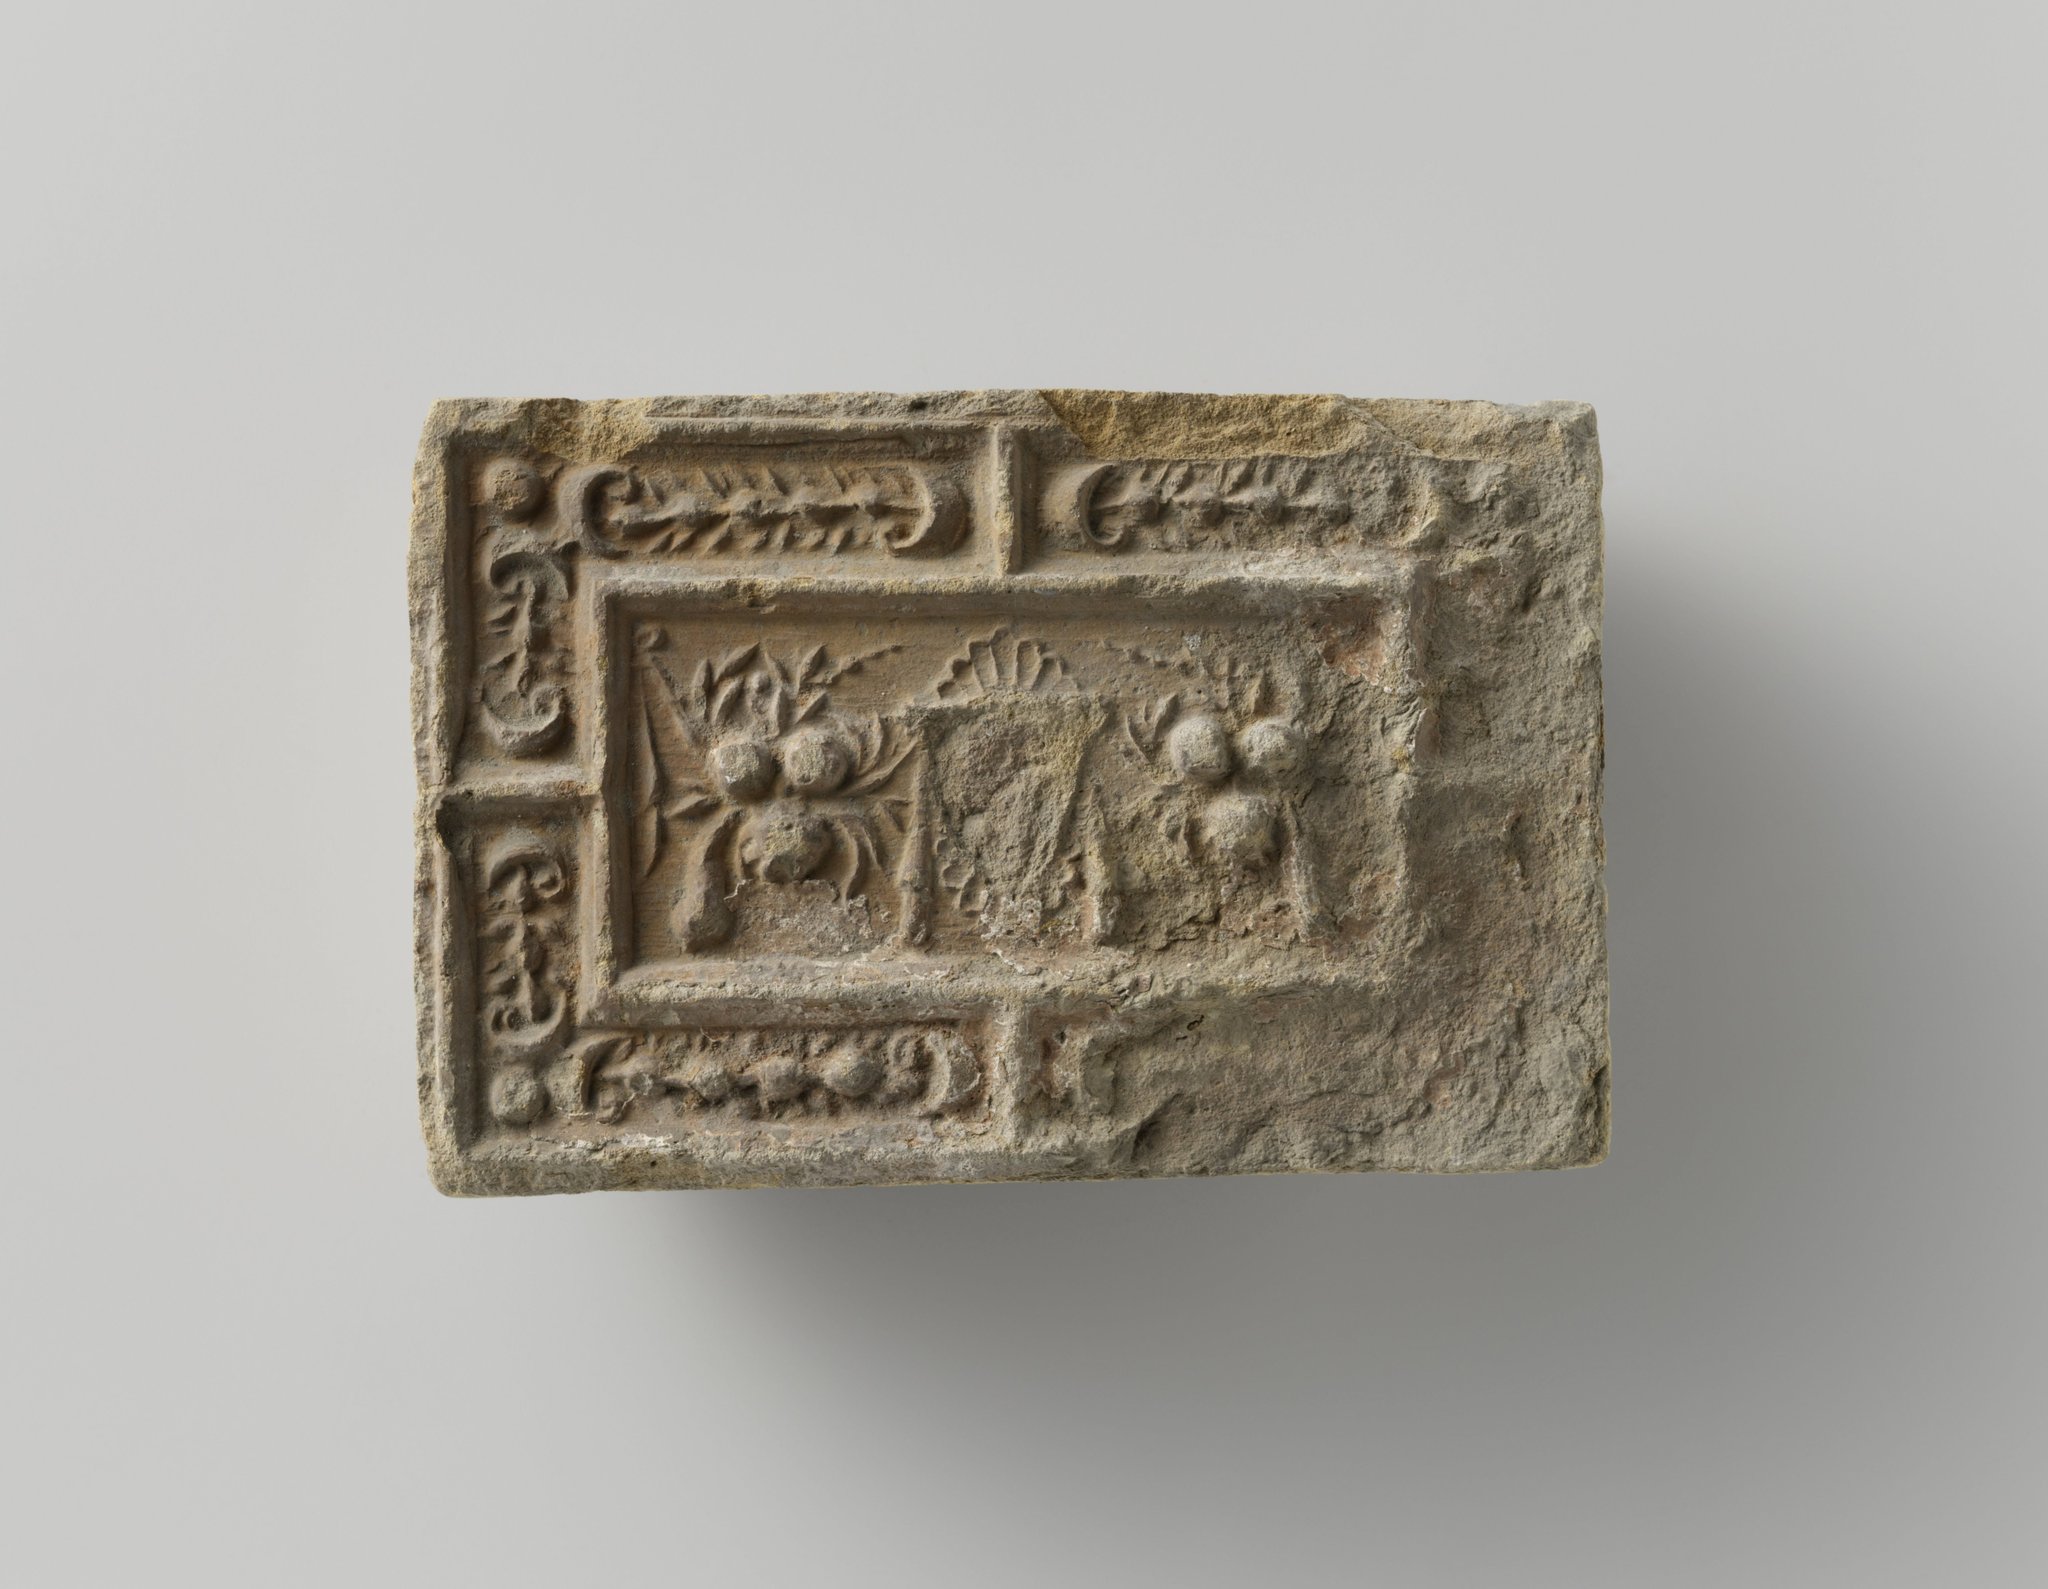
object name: hearthstone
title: Haardsteen met voorstelling van een mascaron tussen twee vruchtfestoenen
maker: Anonymous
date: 1575-1600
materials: earthenware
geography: antwerp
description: Haardsteen van gebakken aarde, met een langwerpig vierkante cartouche waarin een mascaron en guirlanden van vruchten en daaromheen een doorlopende guirlande.